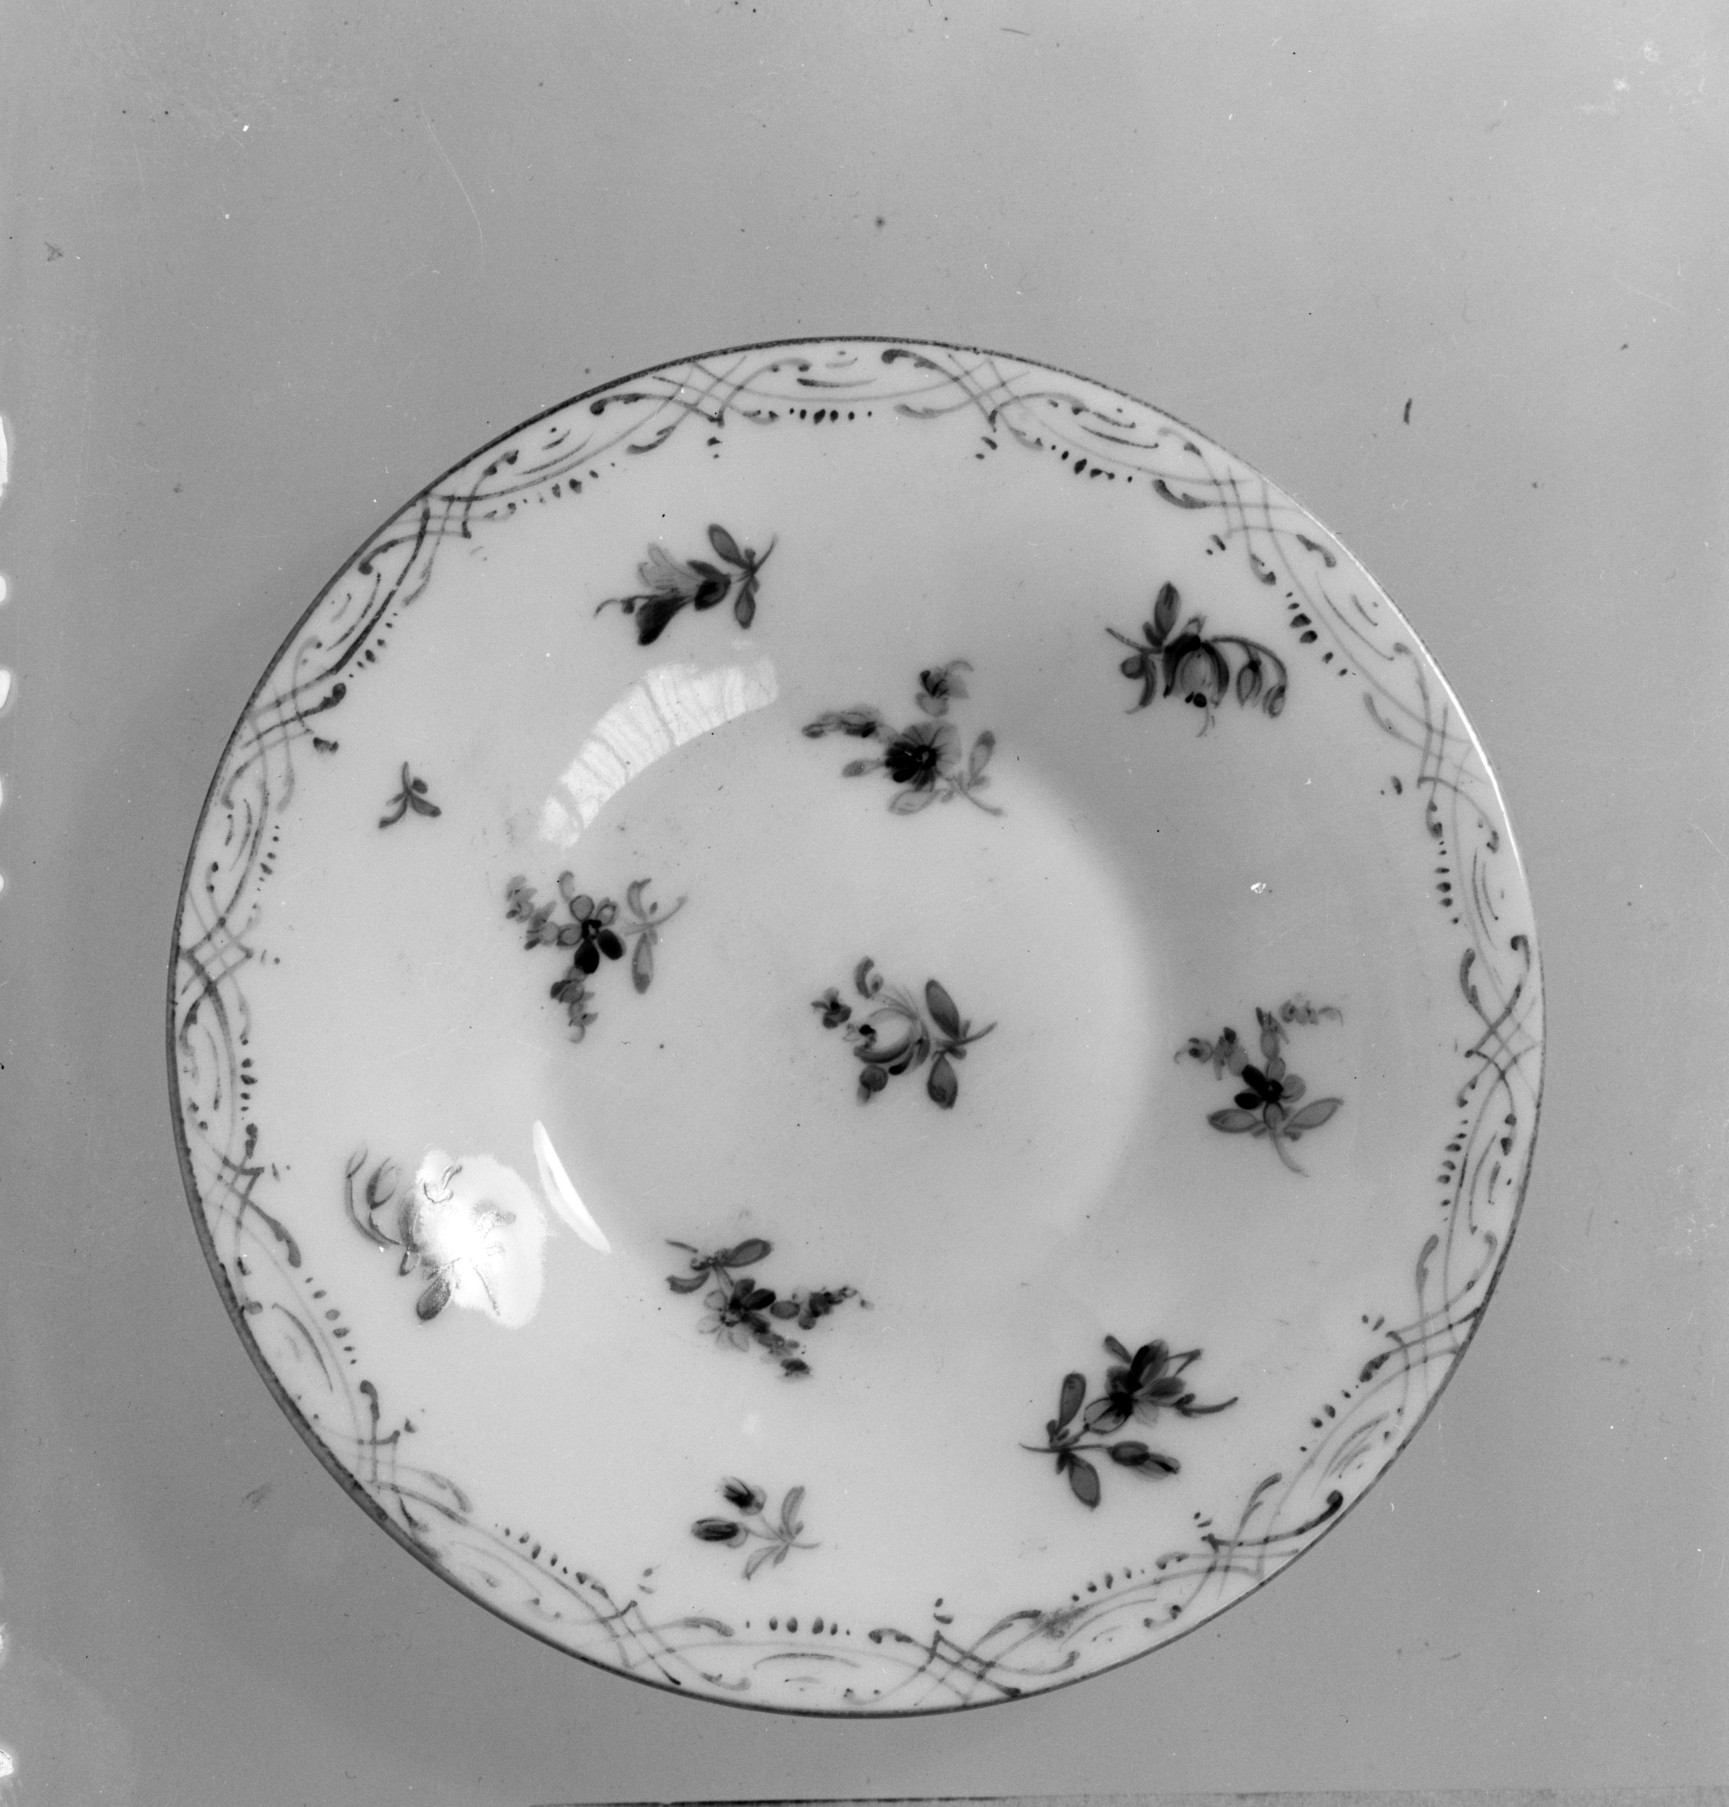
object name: plate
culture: german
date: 1700-1800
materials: earthenware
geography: germany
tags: flowers